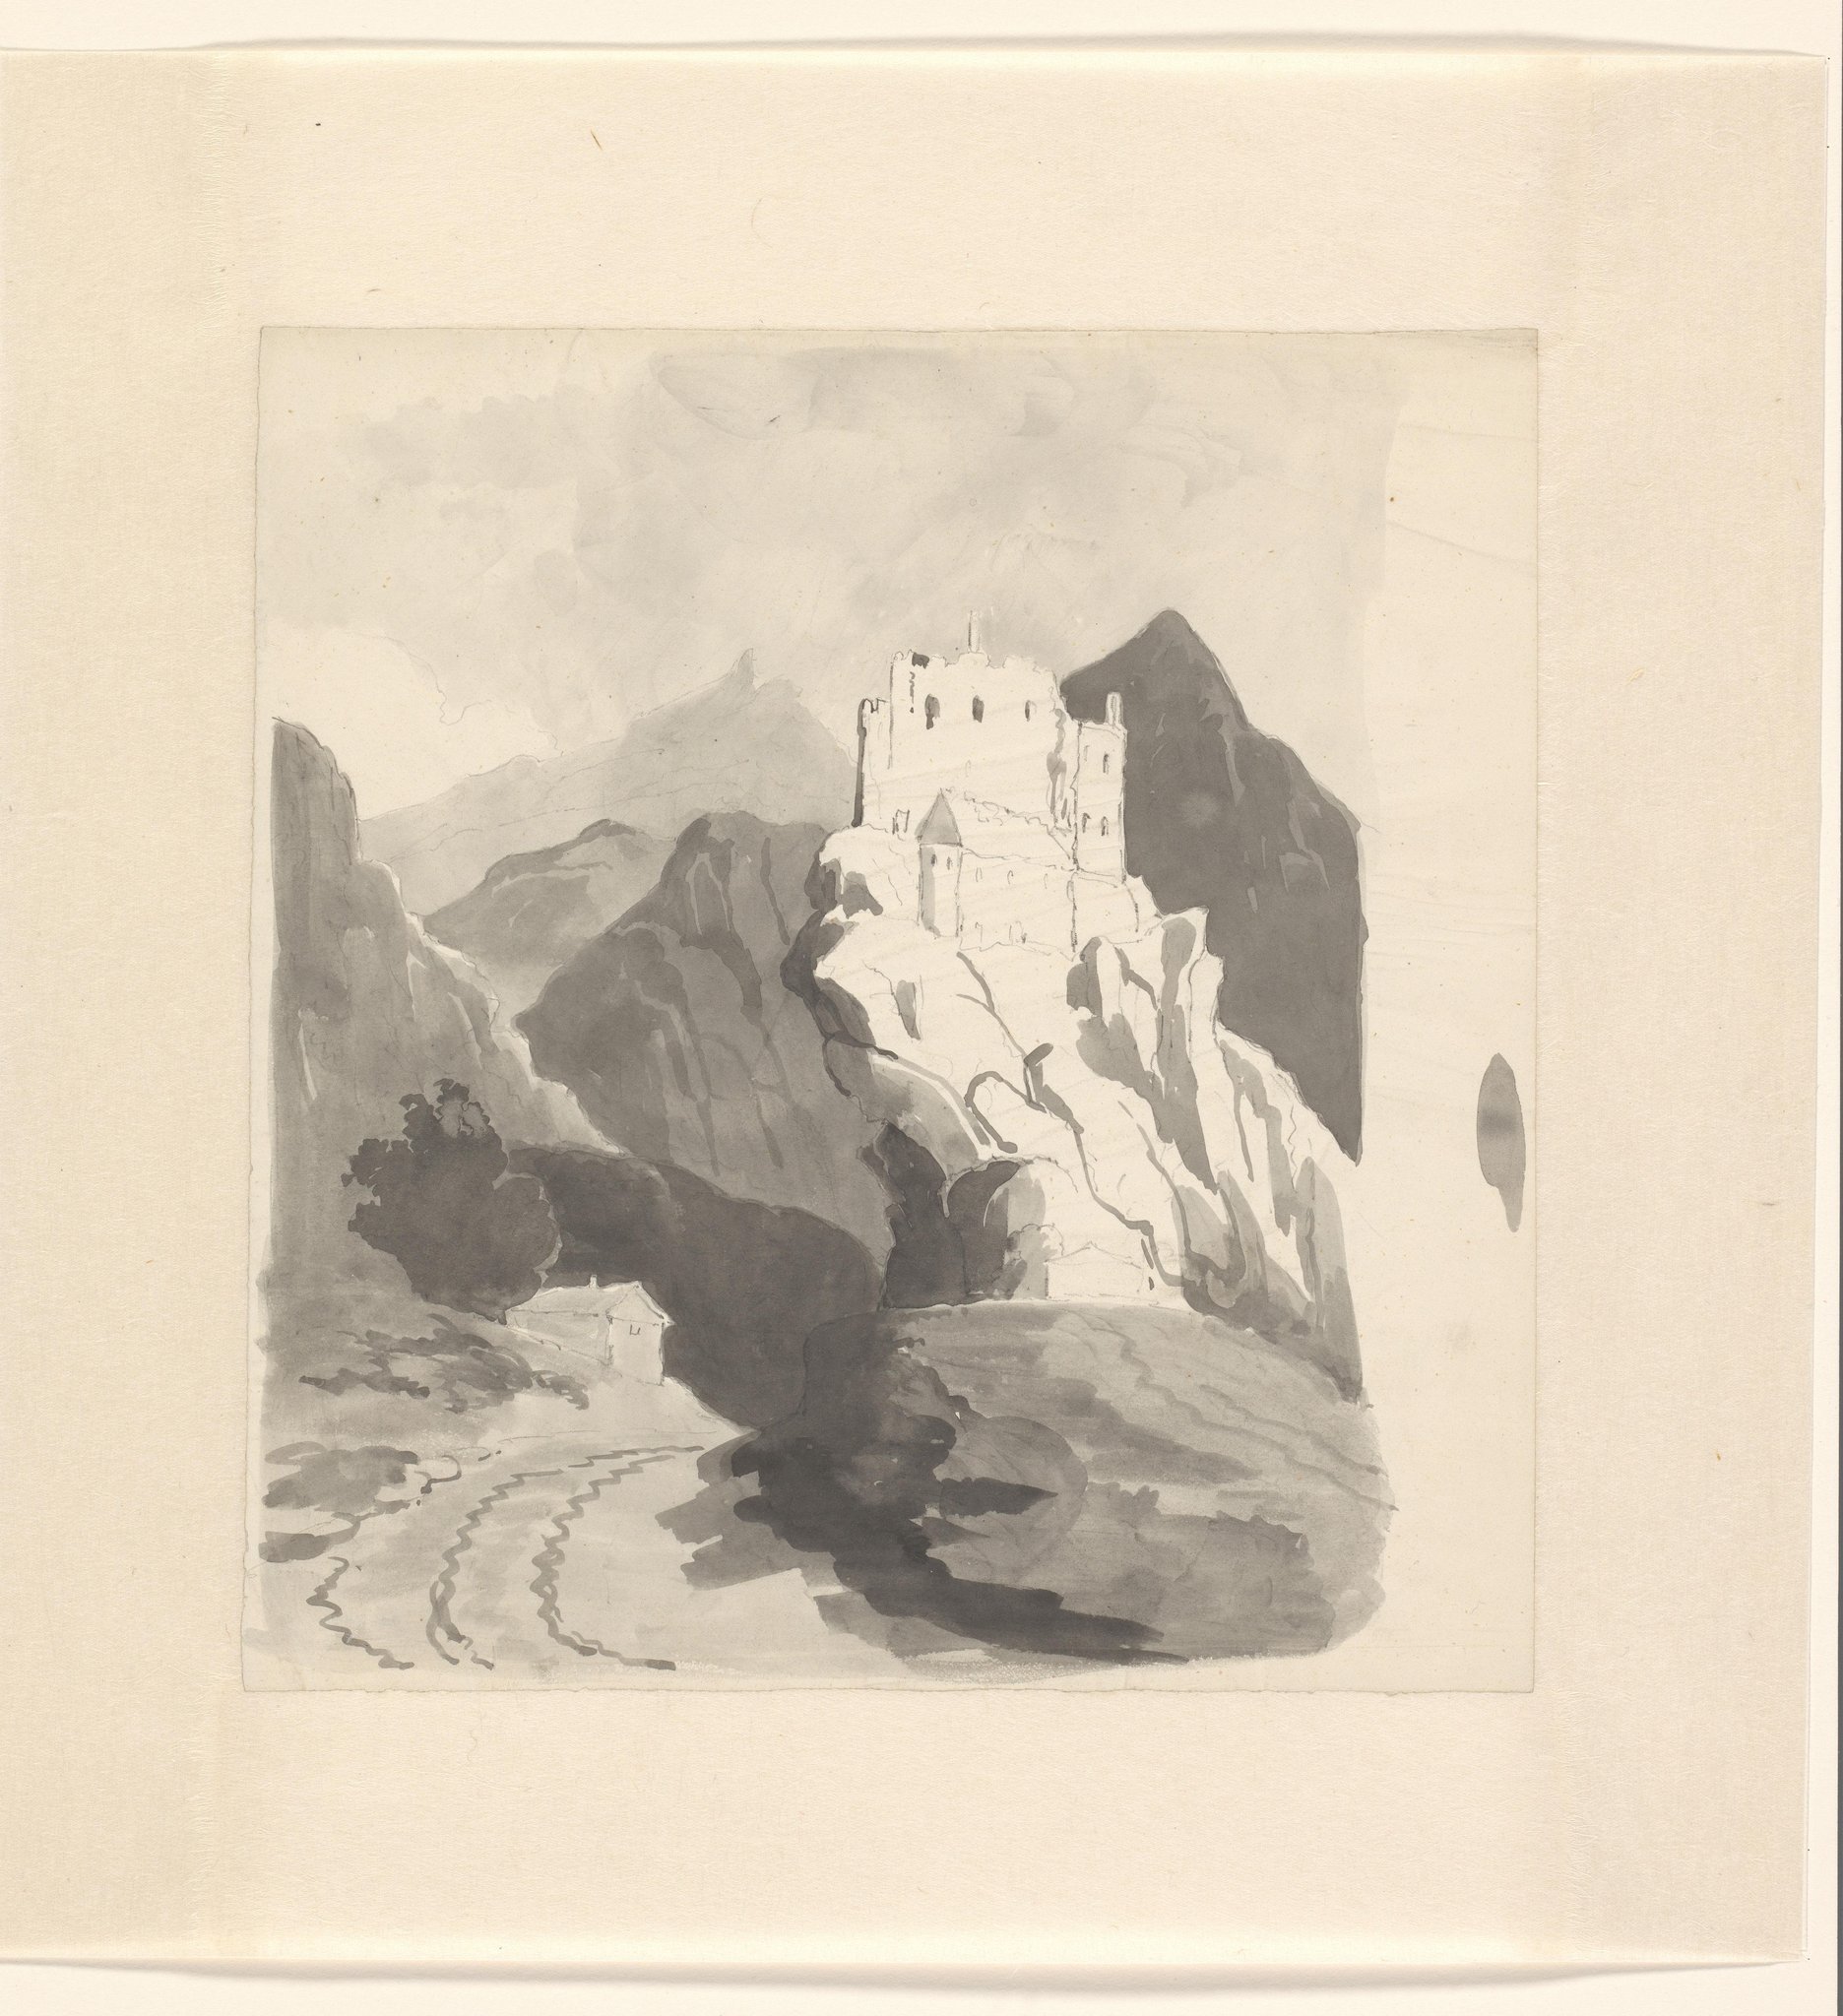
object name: drawing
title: Berglandschap met een kasteel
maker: johannes van reijn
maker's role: draughtsman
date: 1800-1900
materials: paper, pencil, watercolor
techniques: brush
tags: castle, mountains